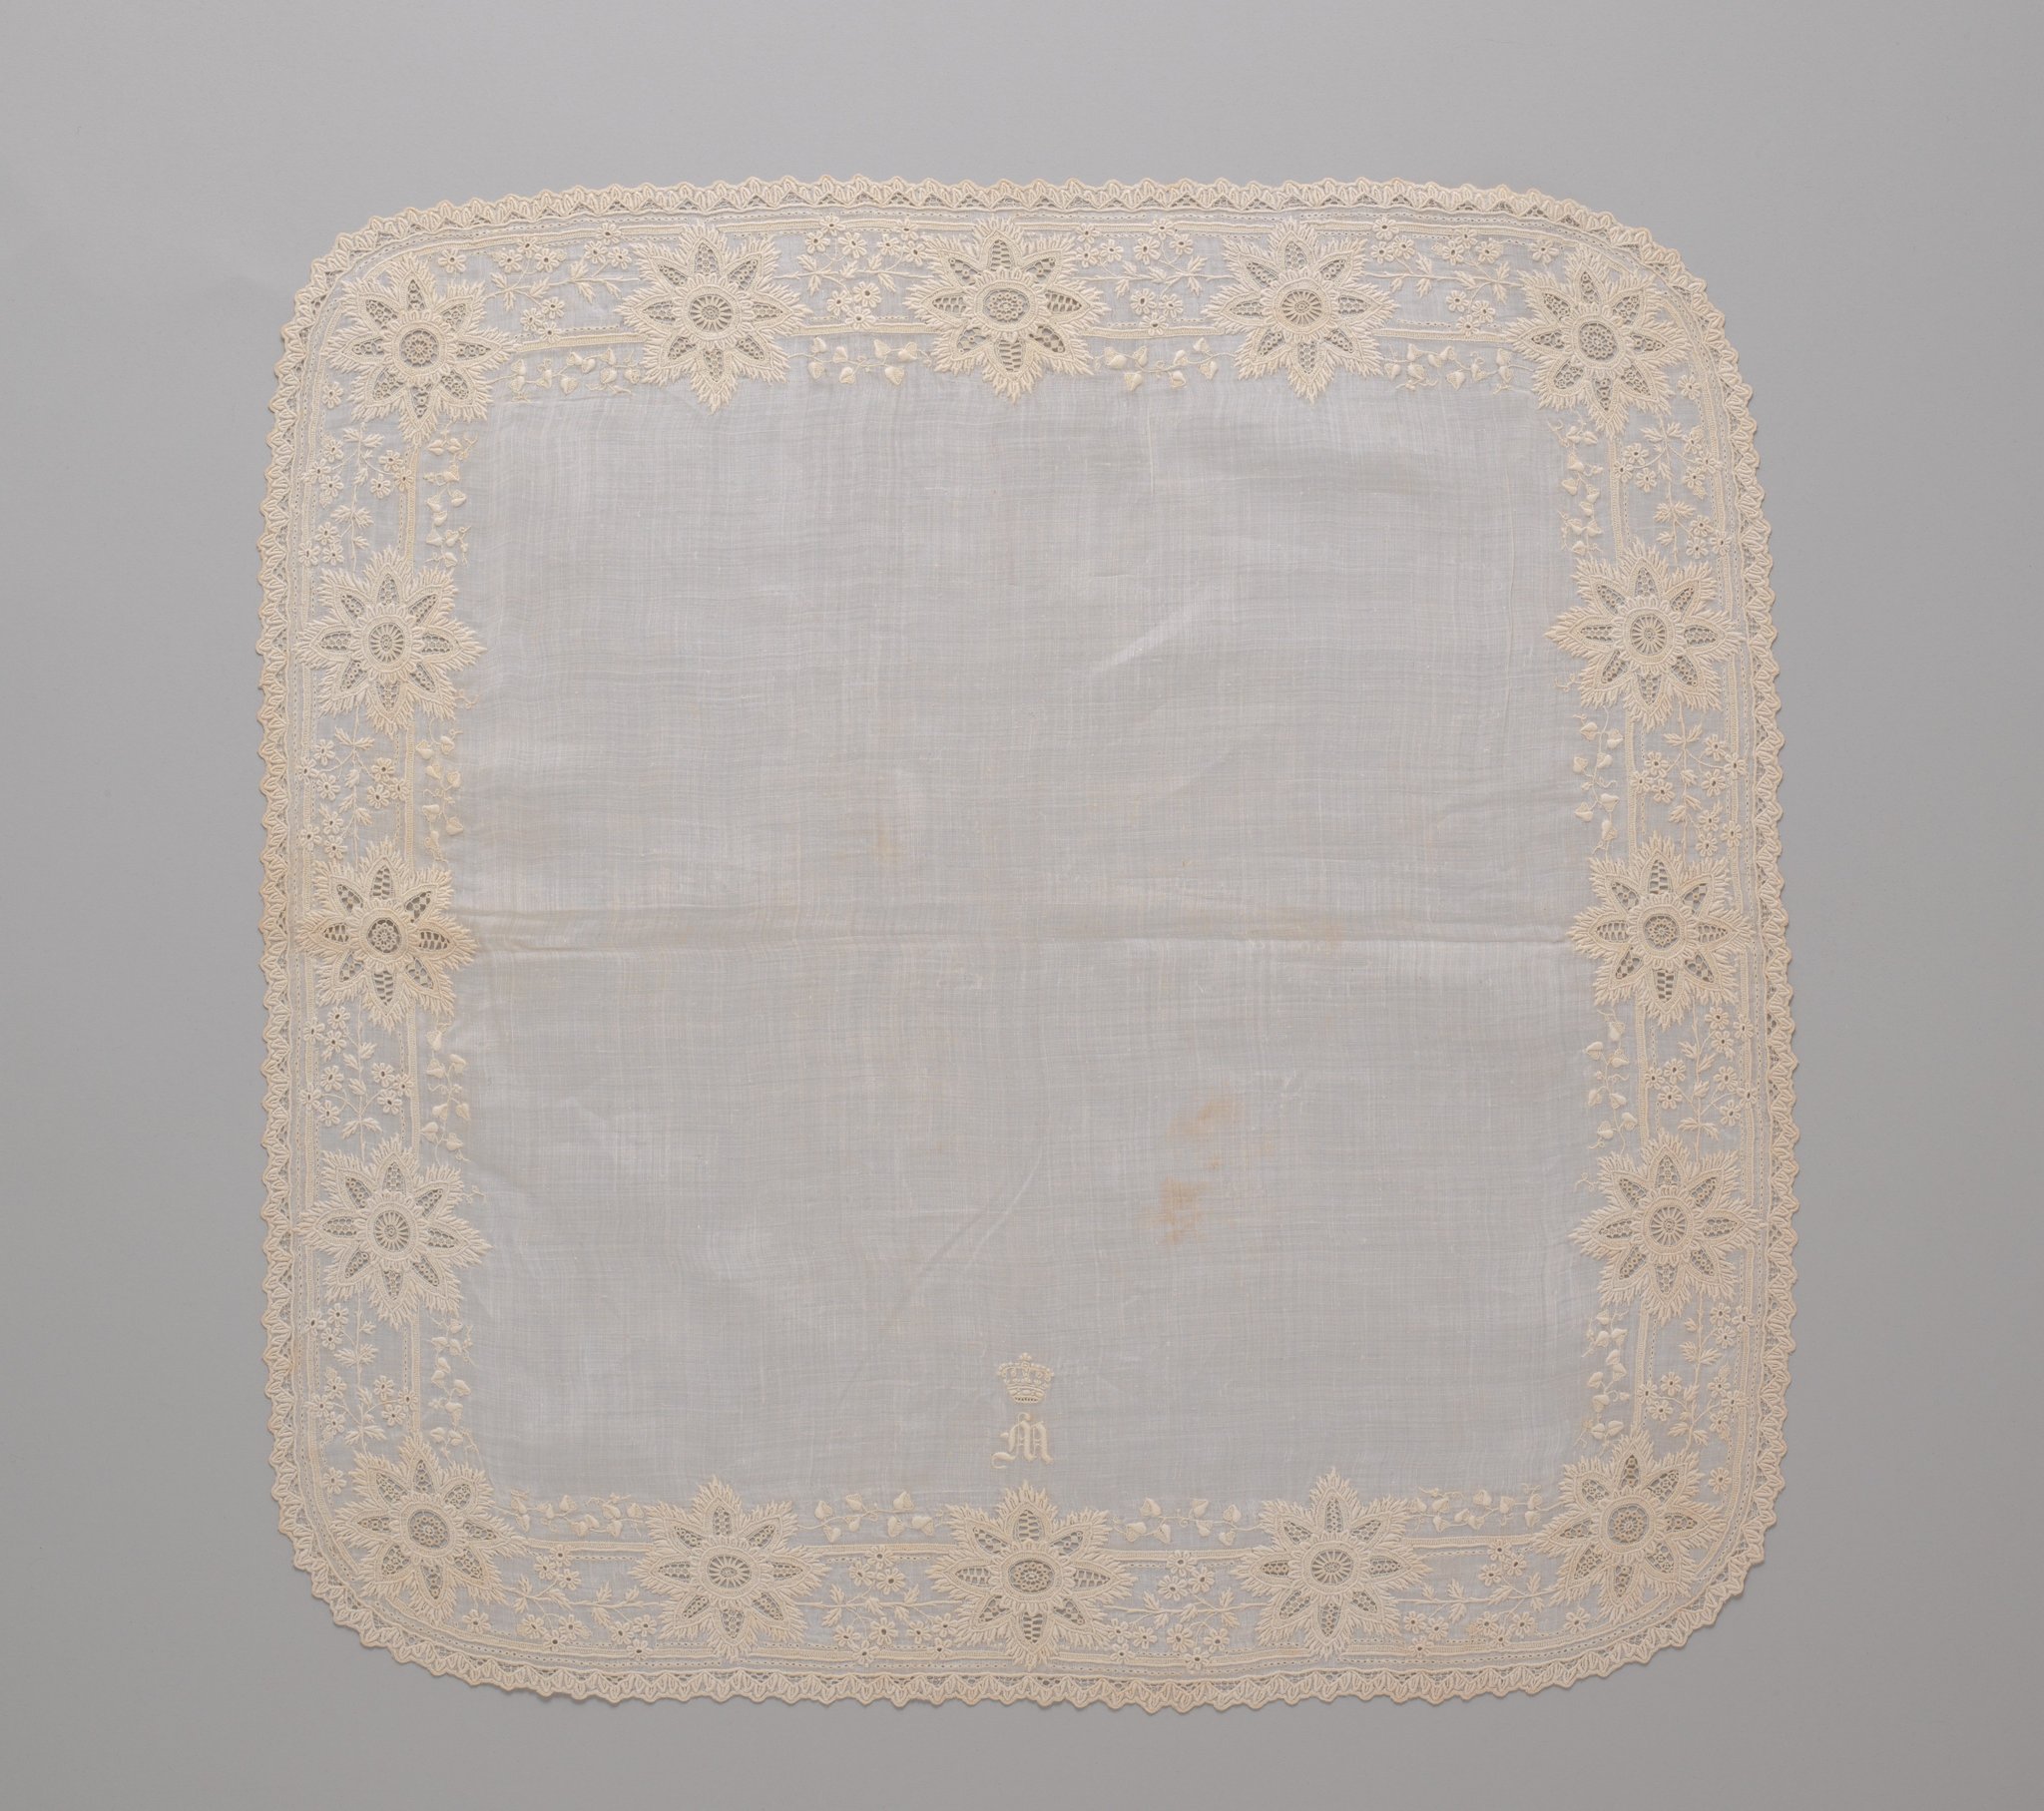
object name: handkerchief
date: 1840-1880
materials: linen, silk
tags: flowers